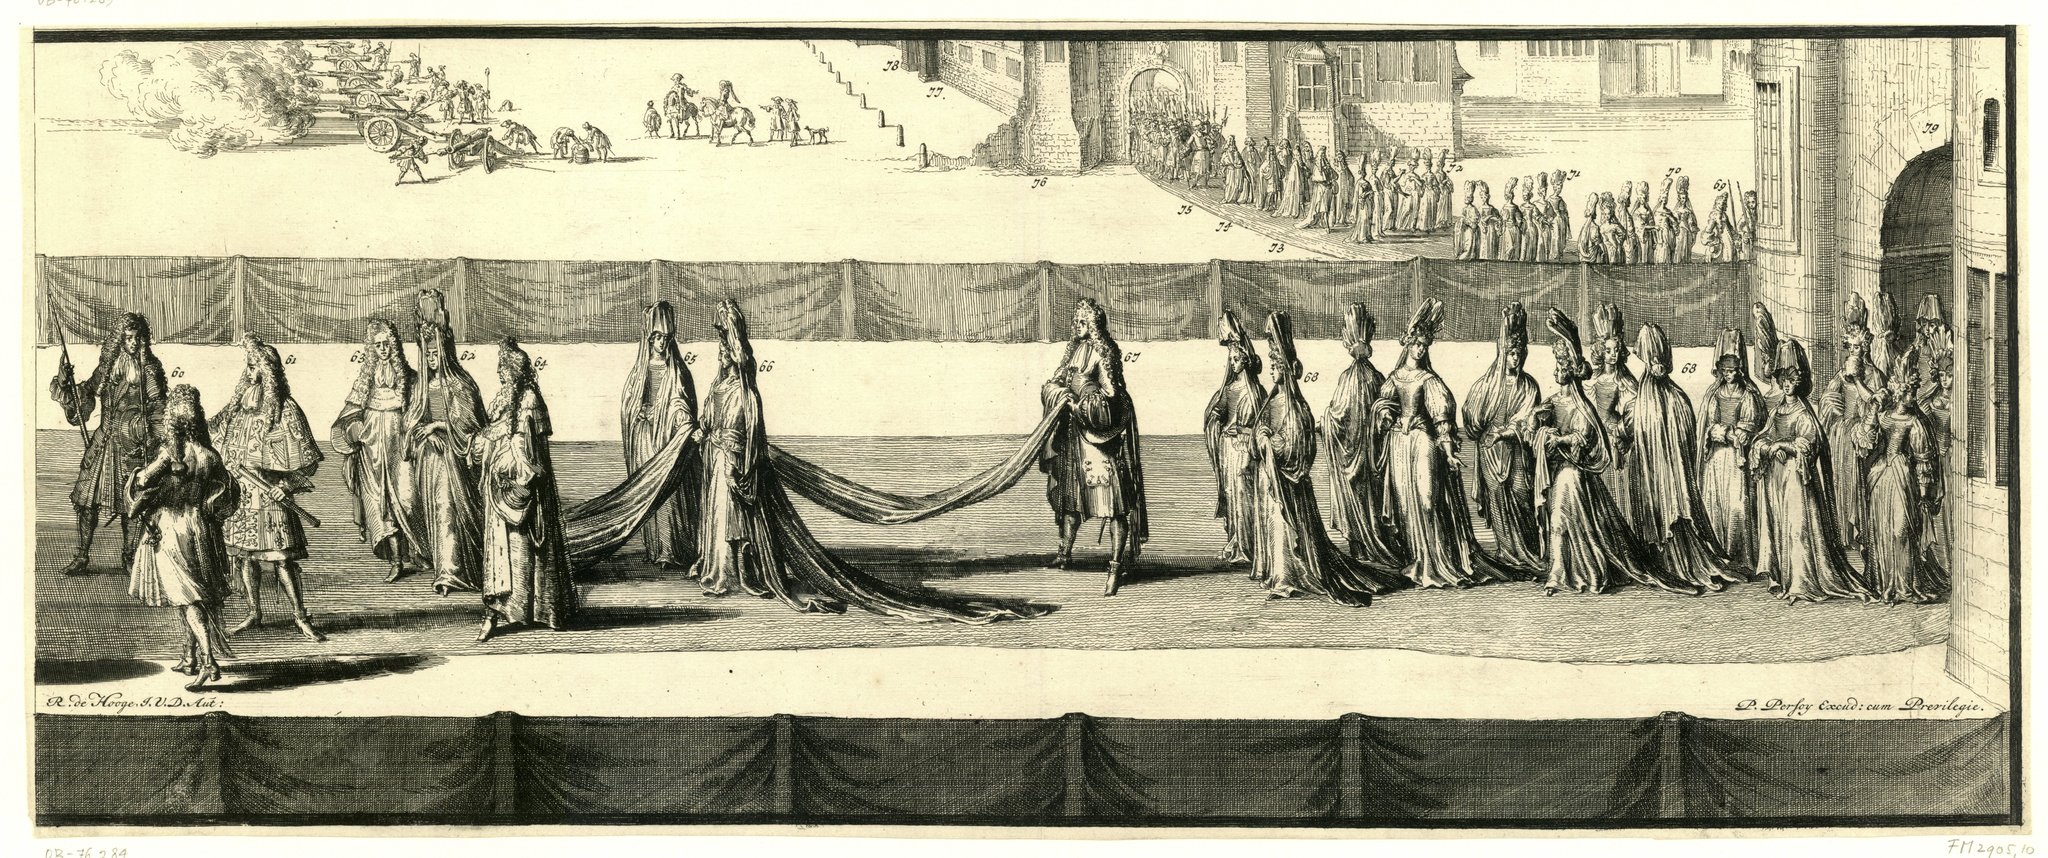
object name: print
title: Het overlijden en de lijkstatie van Maria II Stuart, koningin van Engeland, 1695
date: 1695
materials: paper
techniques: etching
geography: northern netherlands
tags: london, maria ii stuart (koningin van engeland, schotland en ierland), cortege, funeral procession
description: De lijkstatie van de koningin, rechter helft van de derde plaat. Het laatste deel van de stoet dat Whitehall verlaat. Elementen in de prent zijn genummerd 60-79. De prent is als illustratie gebruikt in Samuel Gruterus, Funeralia Mariae II Britanniarum, Haarlem 1695.